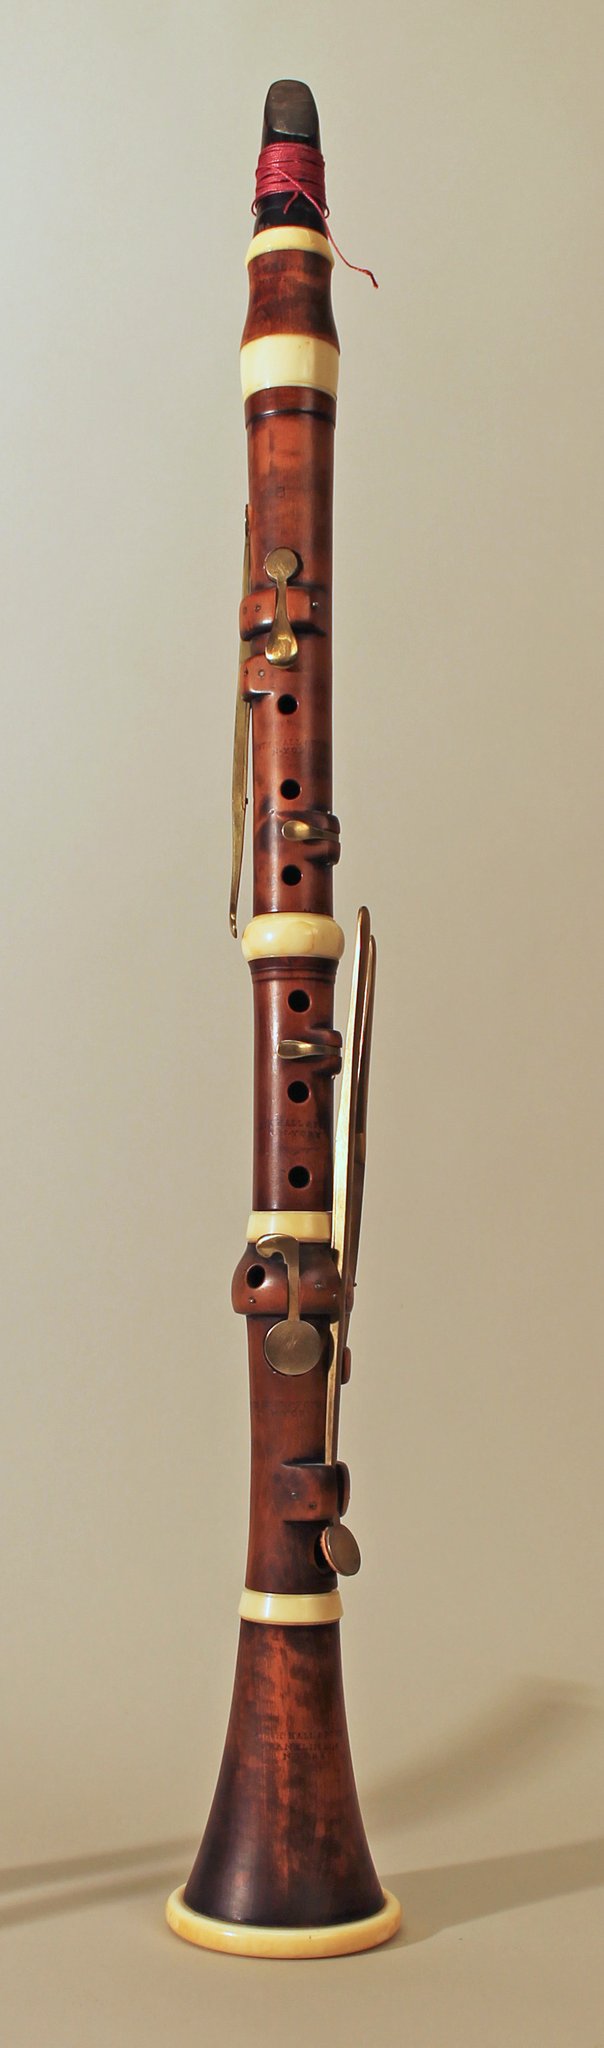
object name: clarinet in c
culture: american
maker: firth, hall & pond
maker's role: maker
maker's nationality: american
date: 1833-1845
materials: brass, ivory, wood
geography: united states